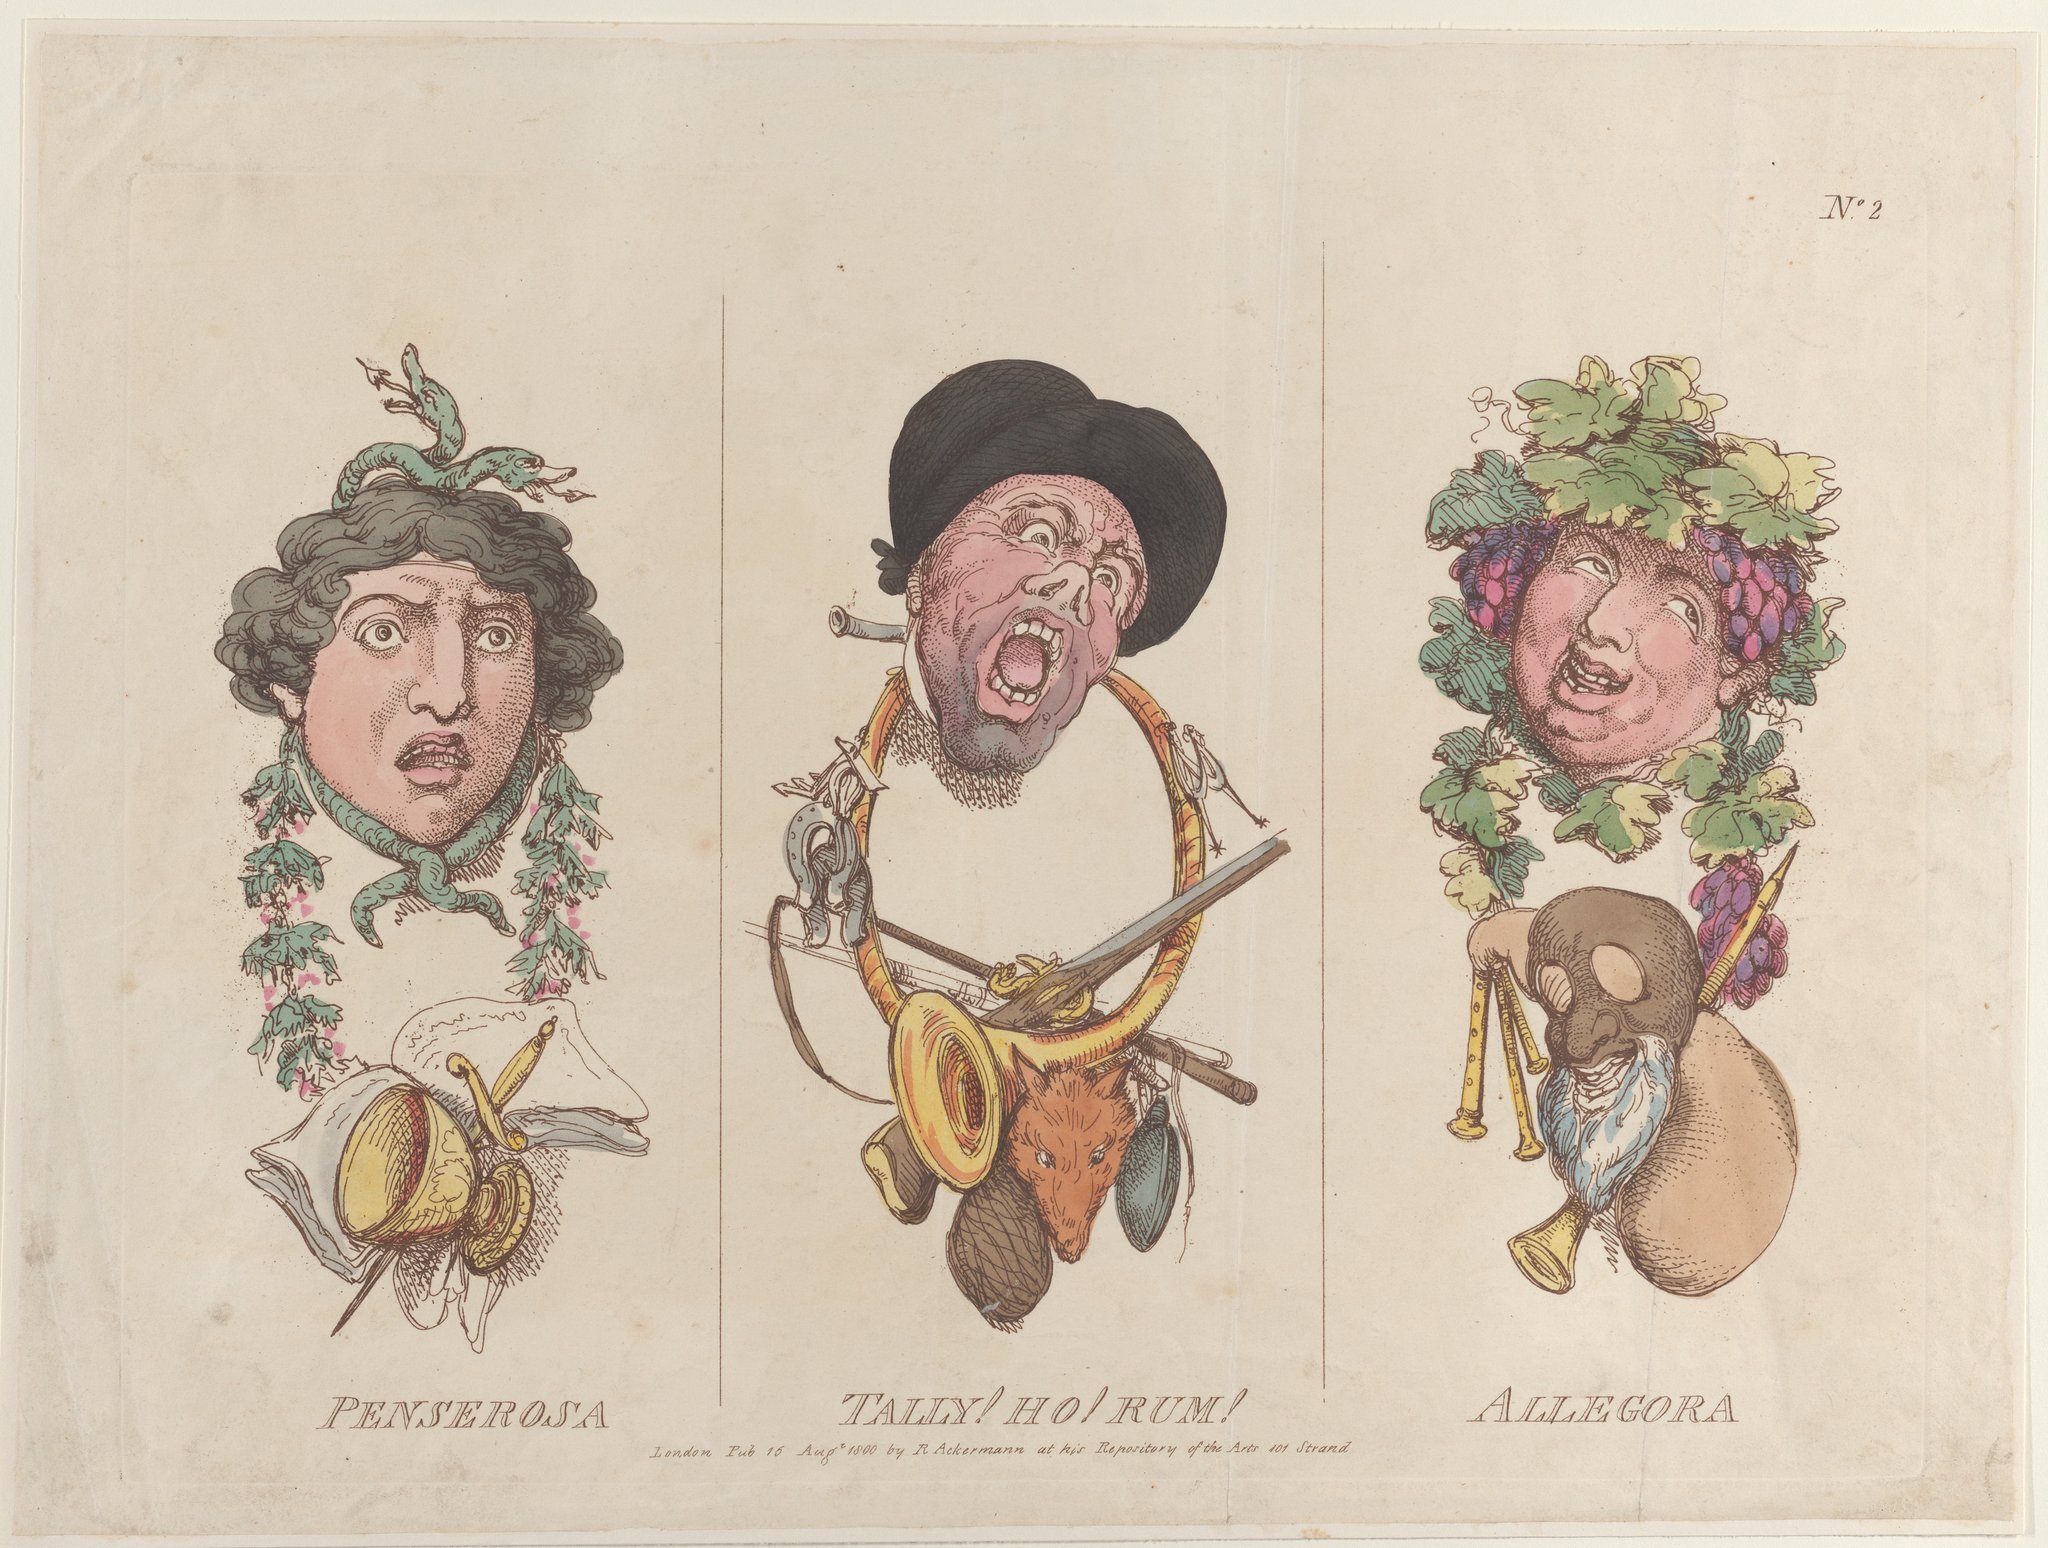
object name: print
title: Penserosa, Tally! Ho! Rum!, Allegora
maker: thomas rowlandson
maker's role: artist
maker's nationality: british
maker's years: 1757-1827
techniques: etching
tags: satire,men